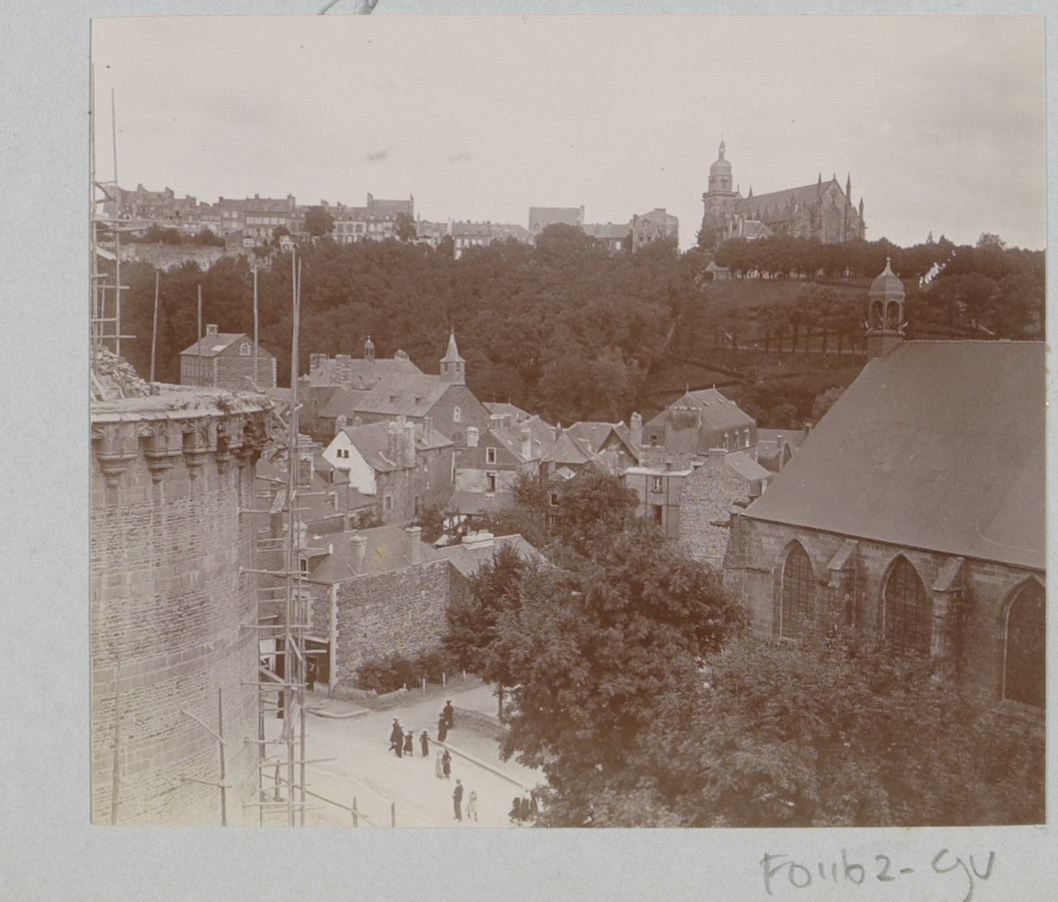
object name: photograph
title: Gezicht op een stad in Frankrijk met een hooggelegen kerk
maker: Anonymous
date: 1905-1910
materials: paper, photographic support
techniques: gelatin silver print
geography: france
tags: church (exterior), prospect of city, town panorama, silhouette of city, france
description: Onderdeel van Fotoalbum van een Franse amateurfotograaf met bezienswaardigheden in Frankrijk, Zwitserland en Italië.